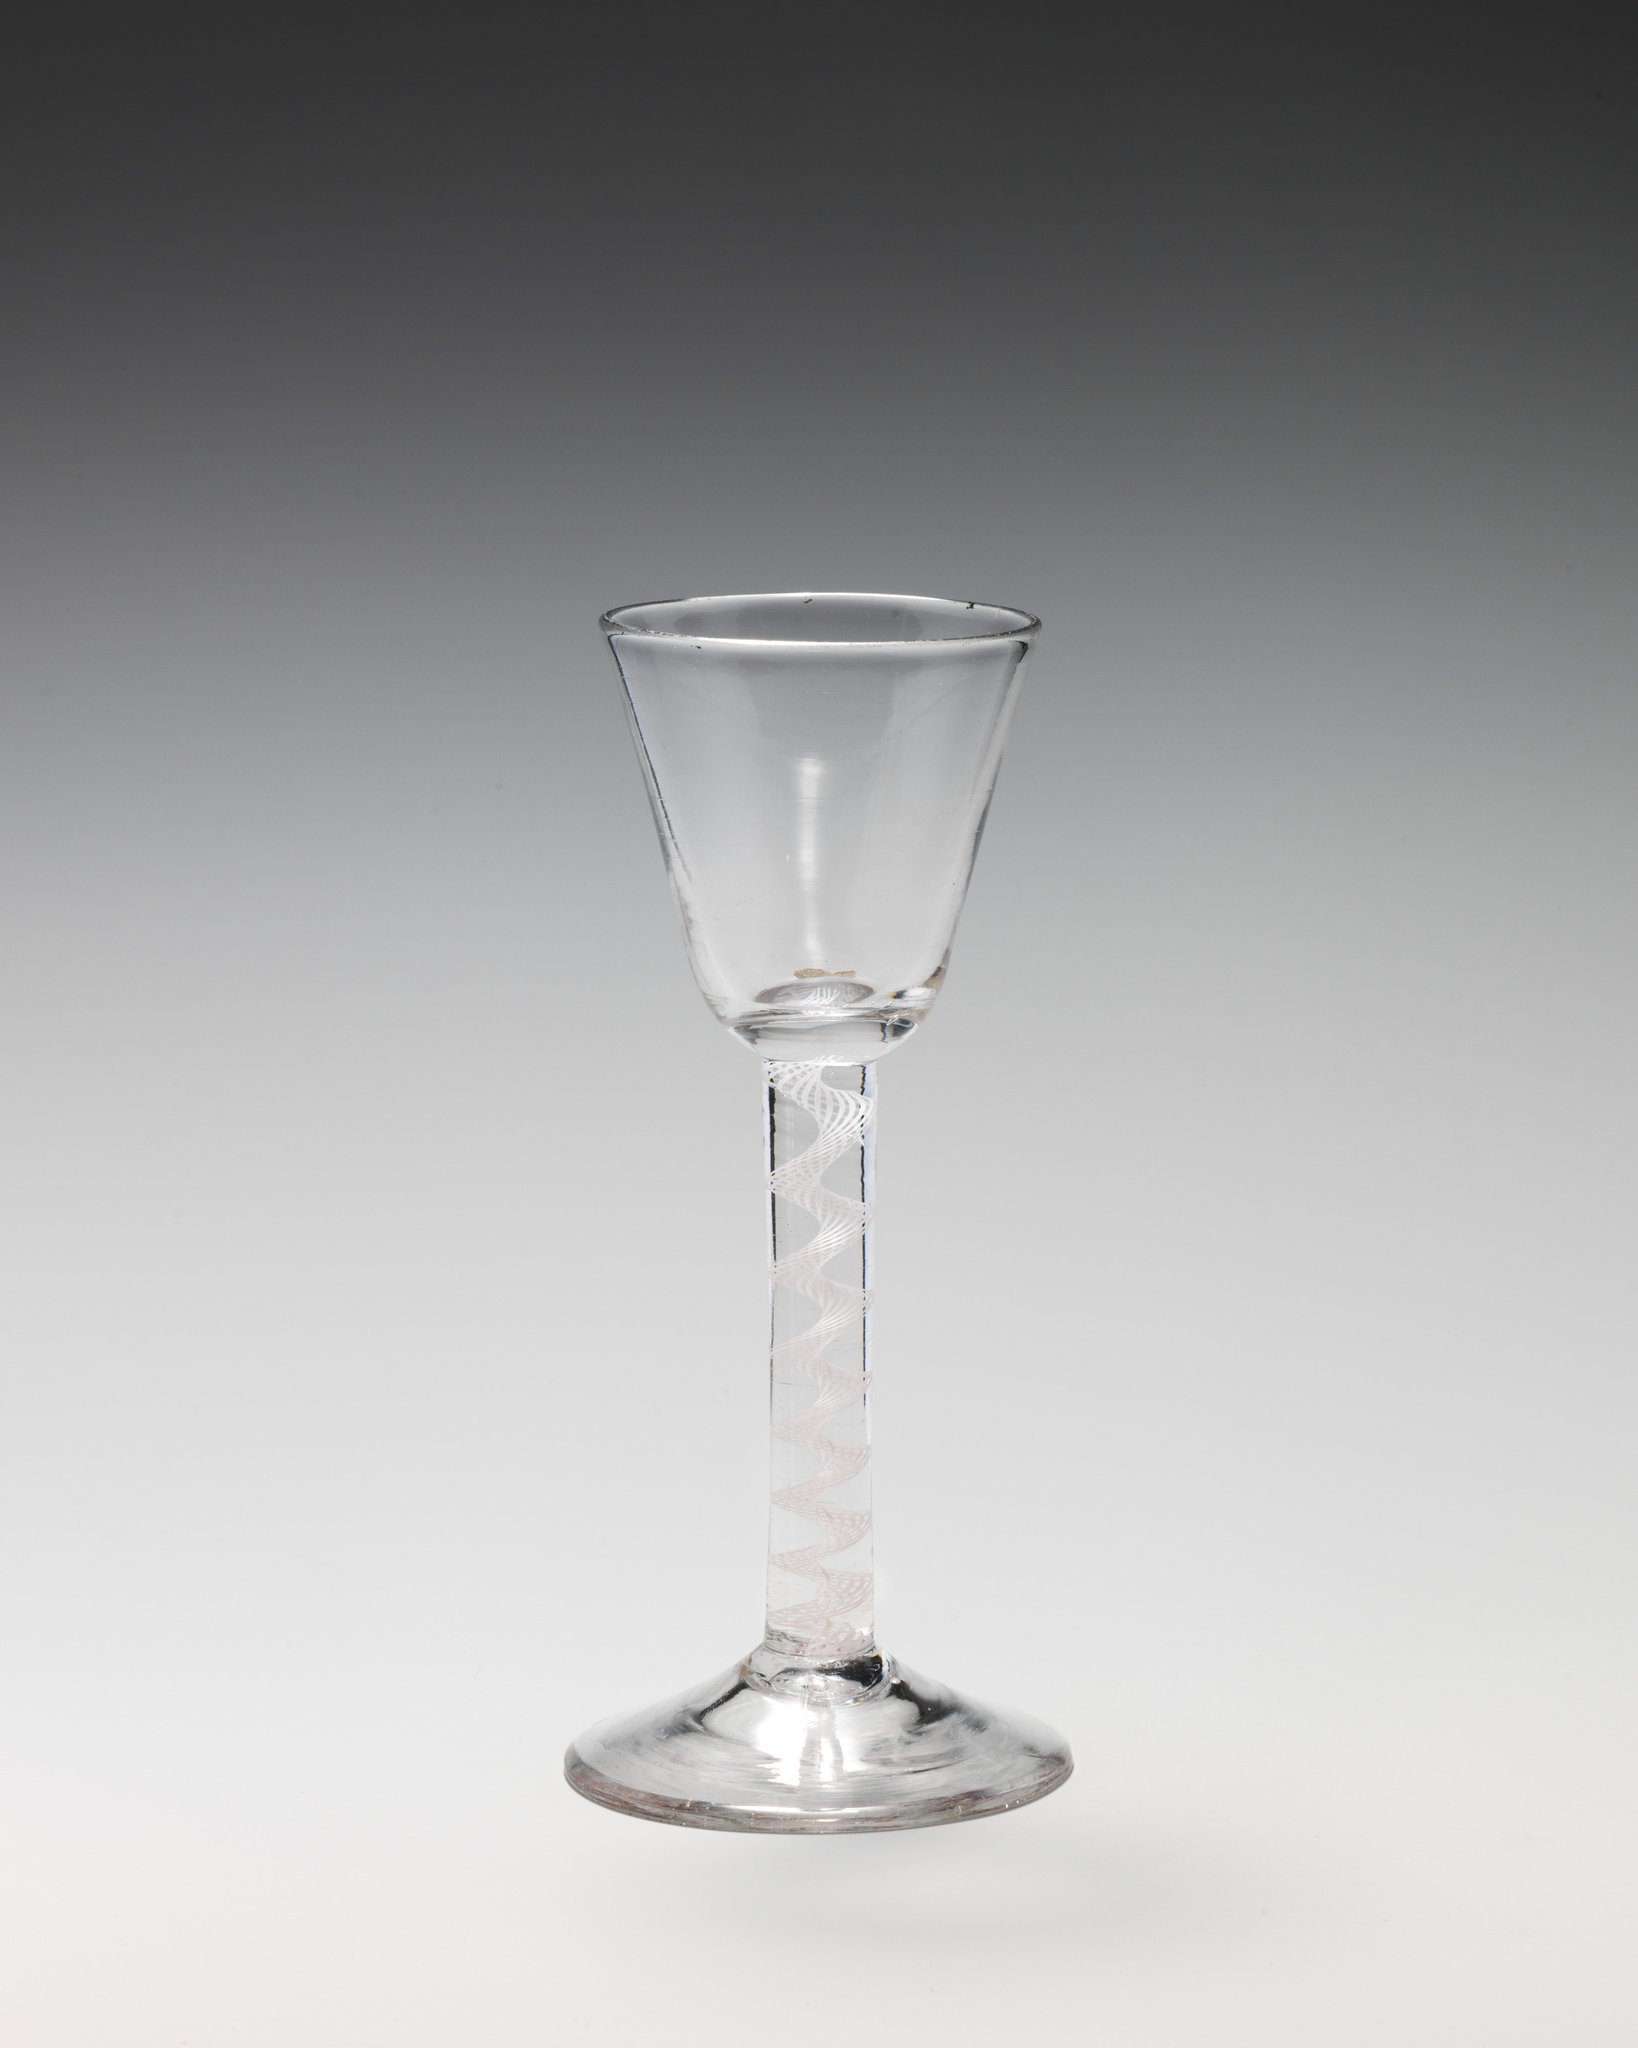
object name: wineglass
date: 1750-1800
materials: glass